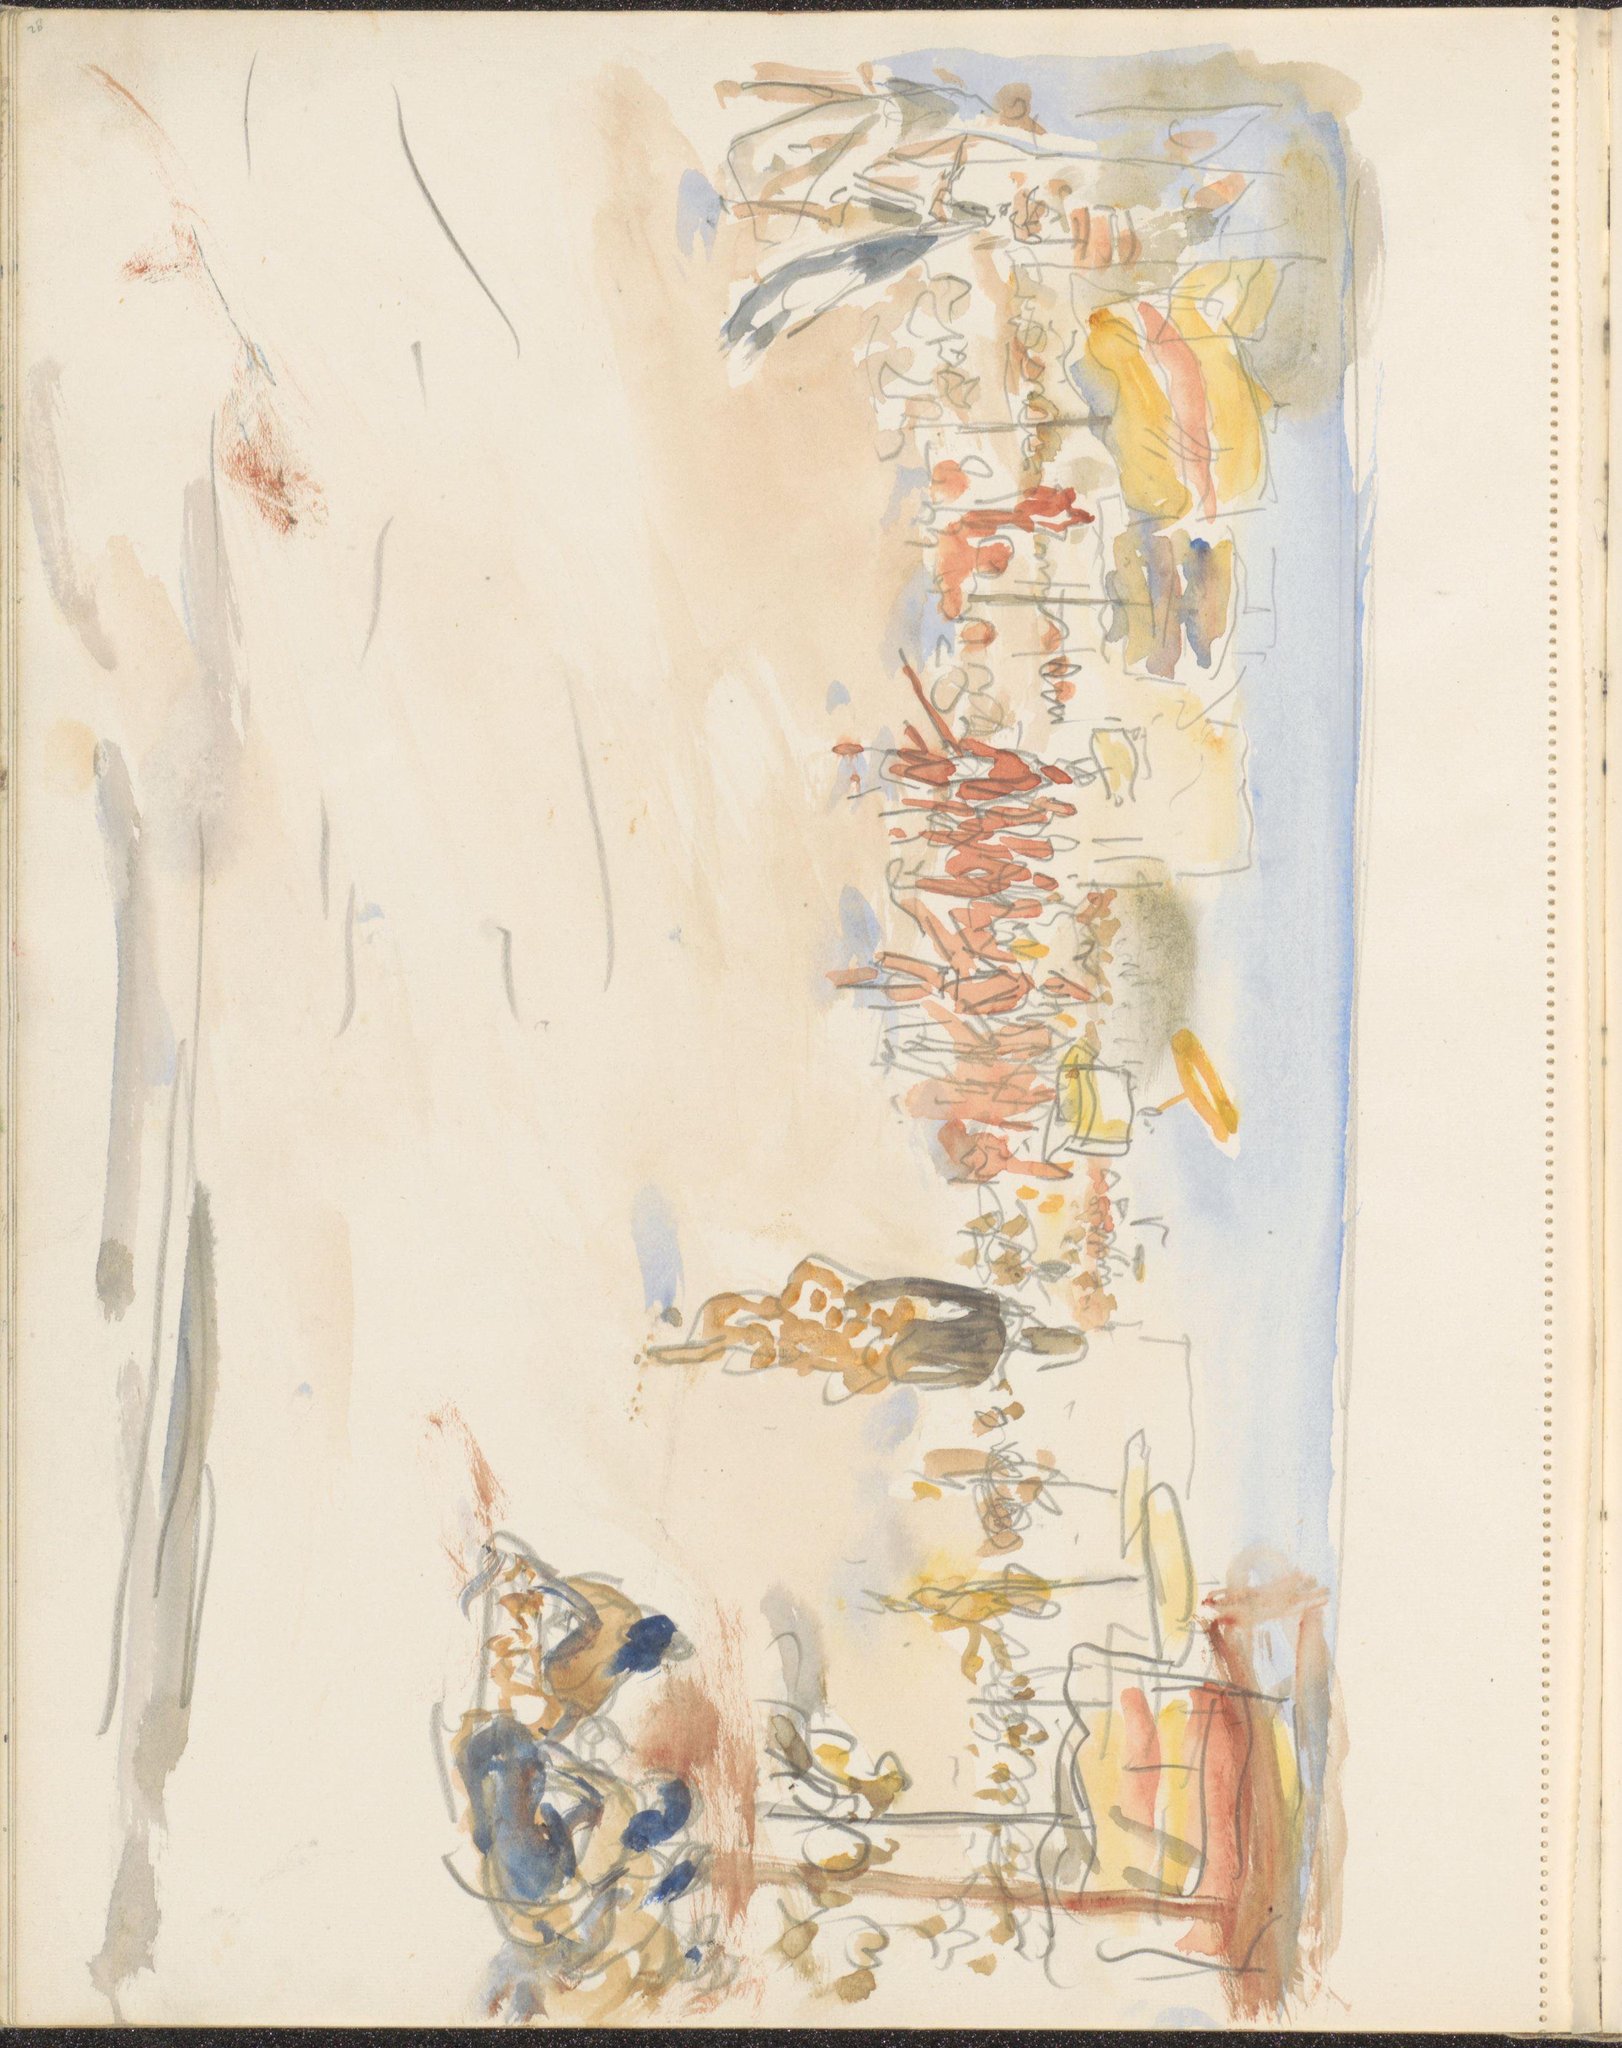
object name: sketchbook leaf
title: Straatscène met een optocht en figuren met parasols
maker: marius bauer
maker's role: draughtsman, print maker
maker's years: 1867-1932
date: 1931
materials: paper, pencil, watercolor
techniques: brush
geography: thailand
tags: parasol, sunshade, street (+ city(-scape) with figures, staffage)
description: Pagina 28 uit een schetsboek met 48 bladen.